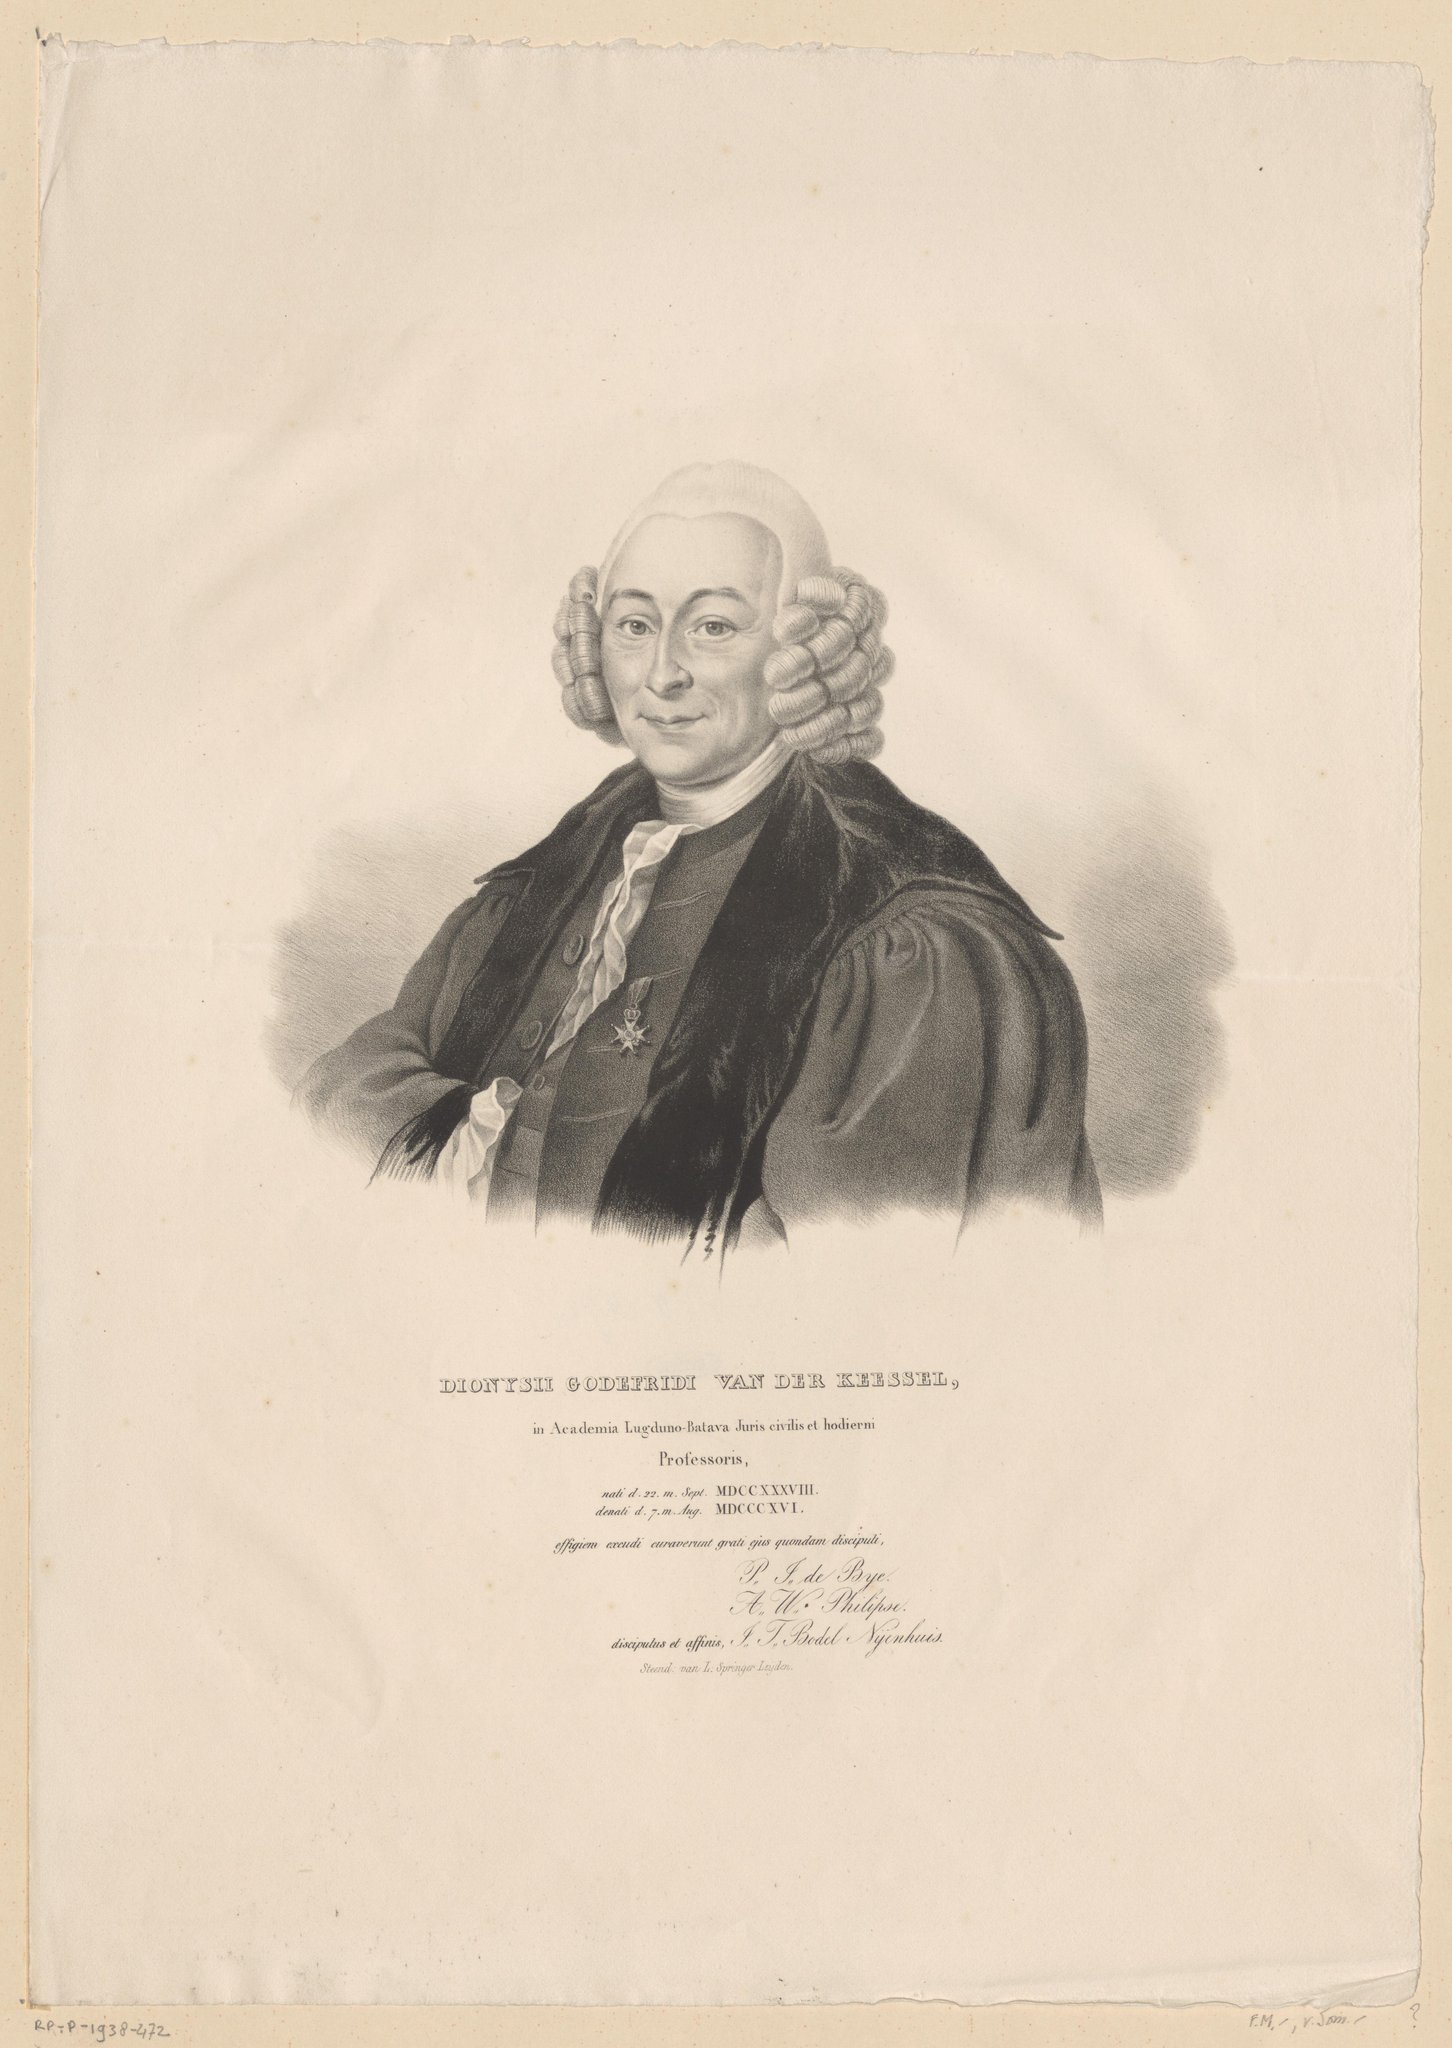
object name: print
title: Portret van Dionysius Godefridus van der Keessel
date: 1828-1836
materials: paper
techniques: lithograph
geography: leiden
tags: deventer, historical persons